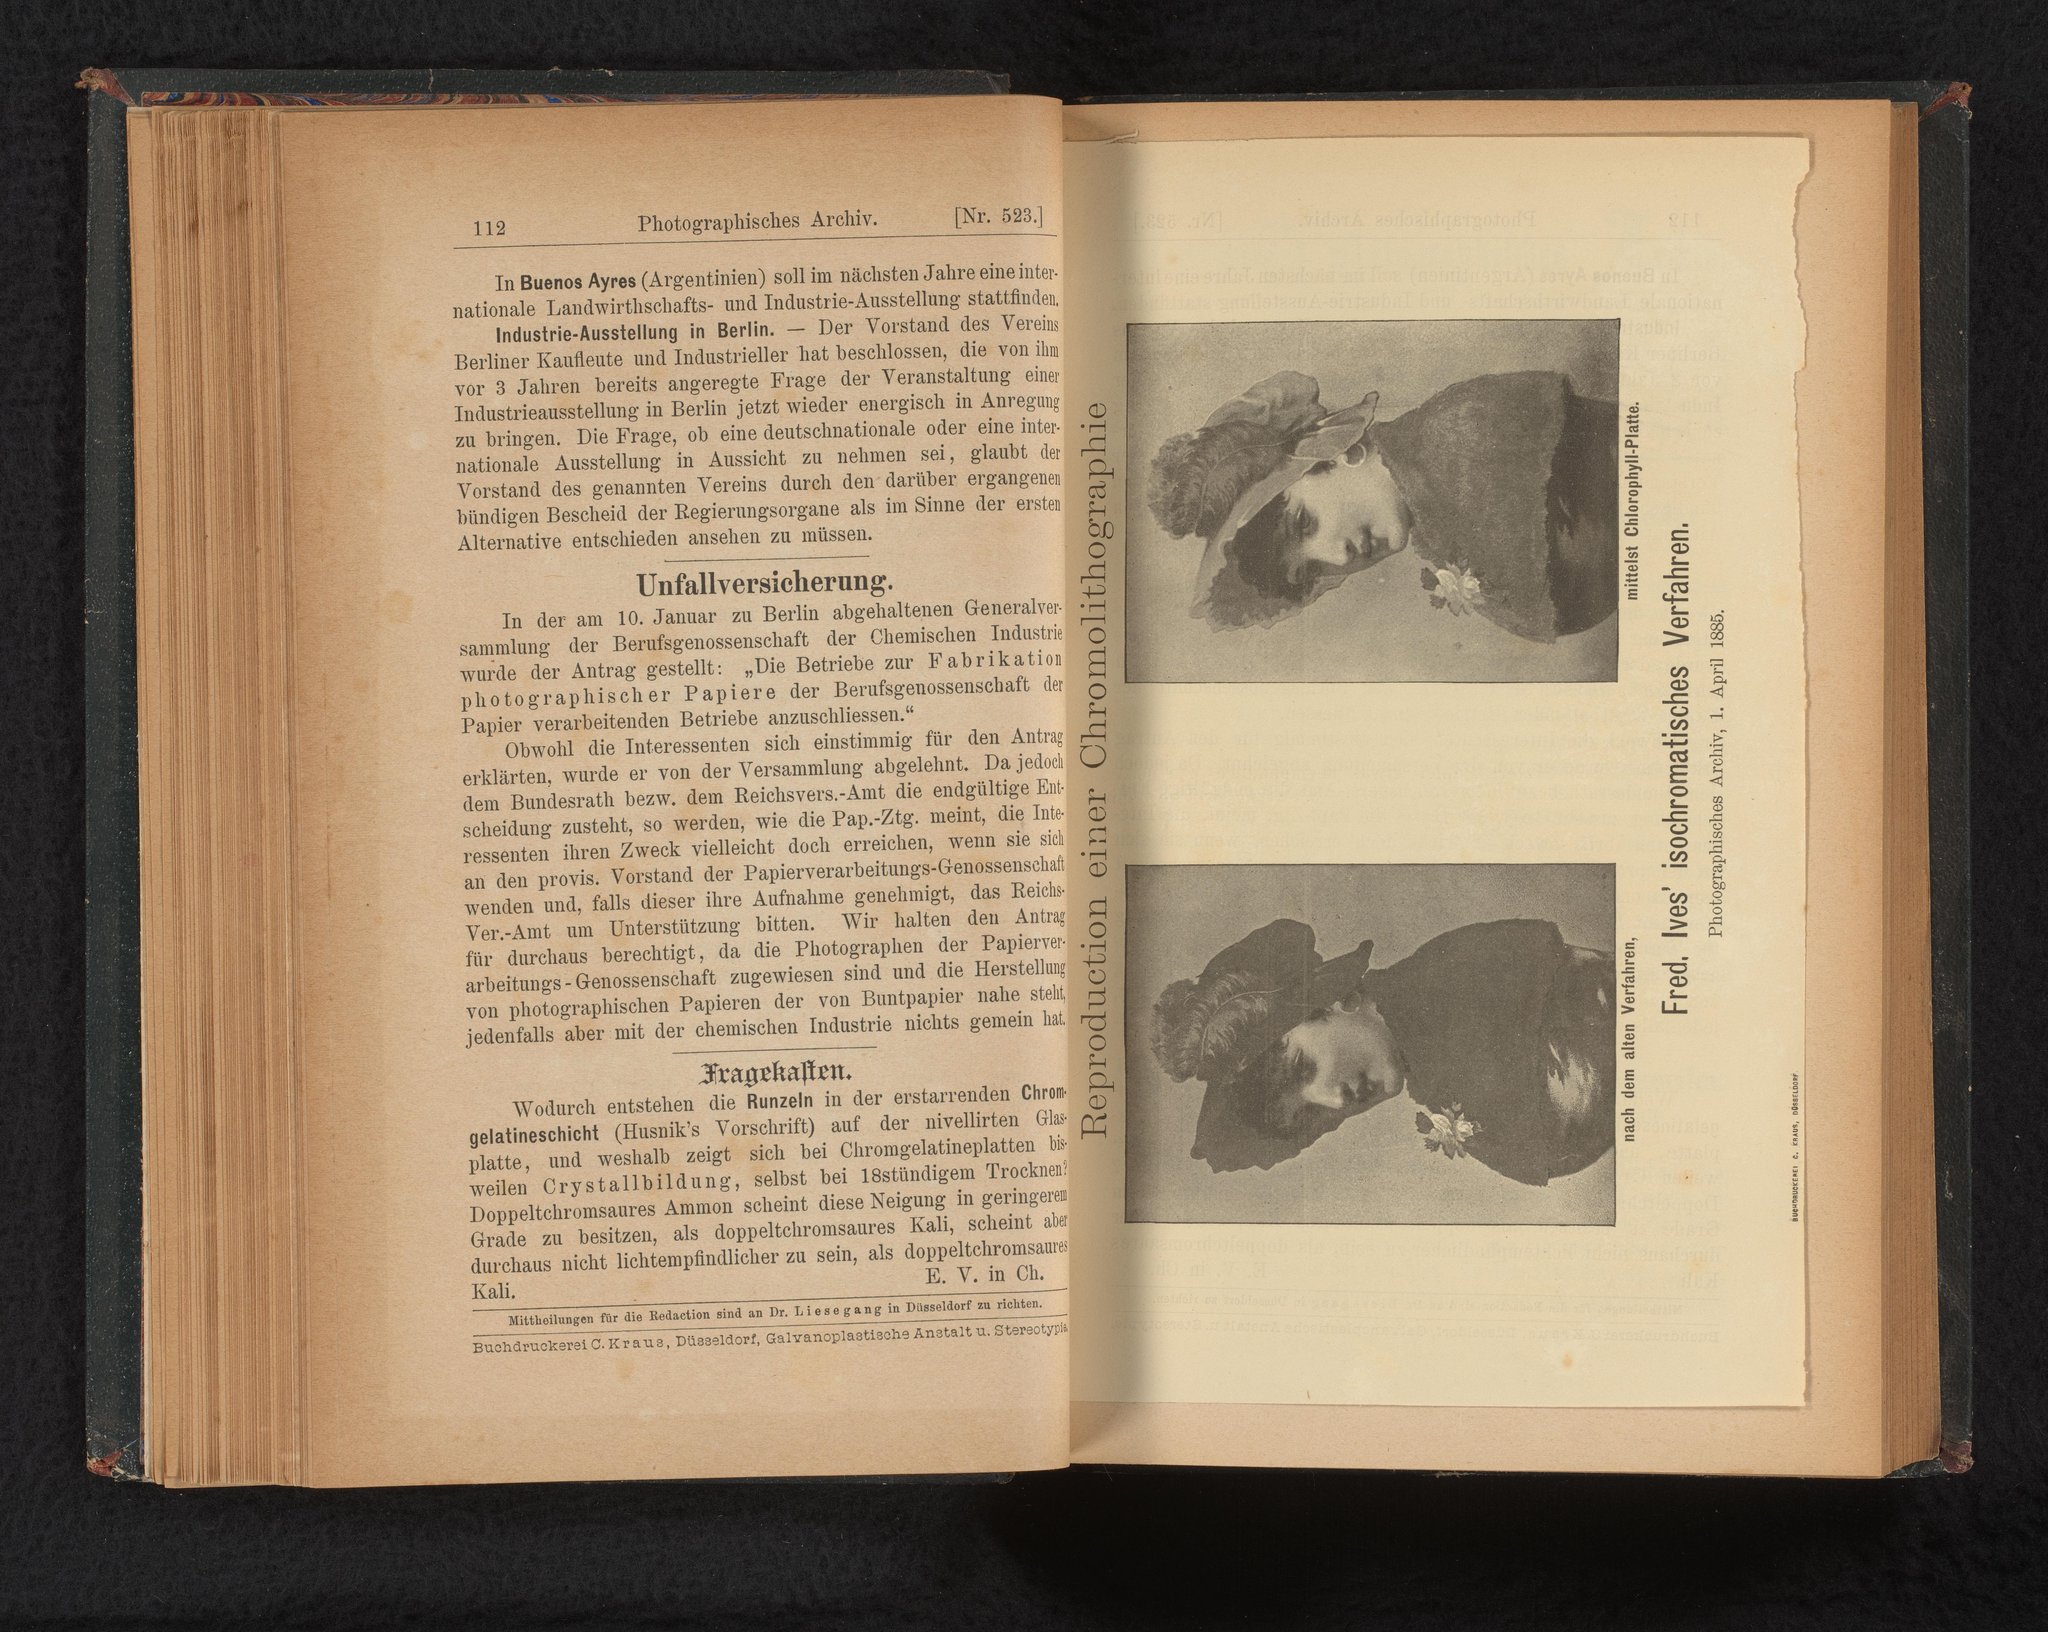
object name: photomechanical print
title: Twee reproducties van een kleurenlithografie van een portret van een onbekende vrouw met hoed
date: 1885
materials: paper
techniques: autotype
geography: dusseldorf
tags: historical persons not known by name - bb - woman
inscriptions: inscription: ‘nach dem alten Verfahren,/ mittelst Chlorophyll-Platte./ Fred. Ives' isochromatisches Verfahren.’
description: Prent op ongenummerde pagina tegenover pagina 112.